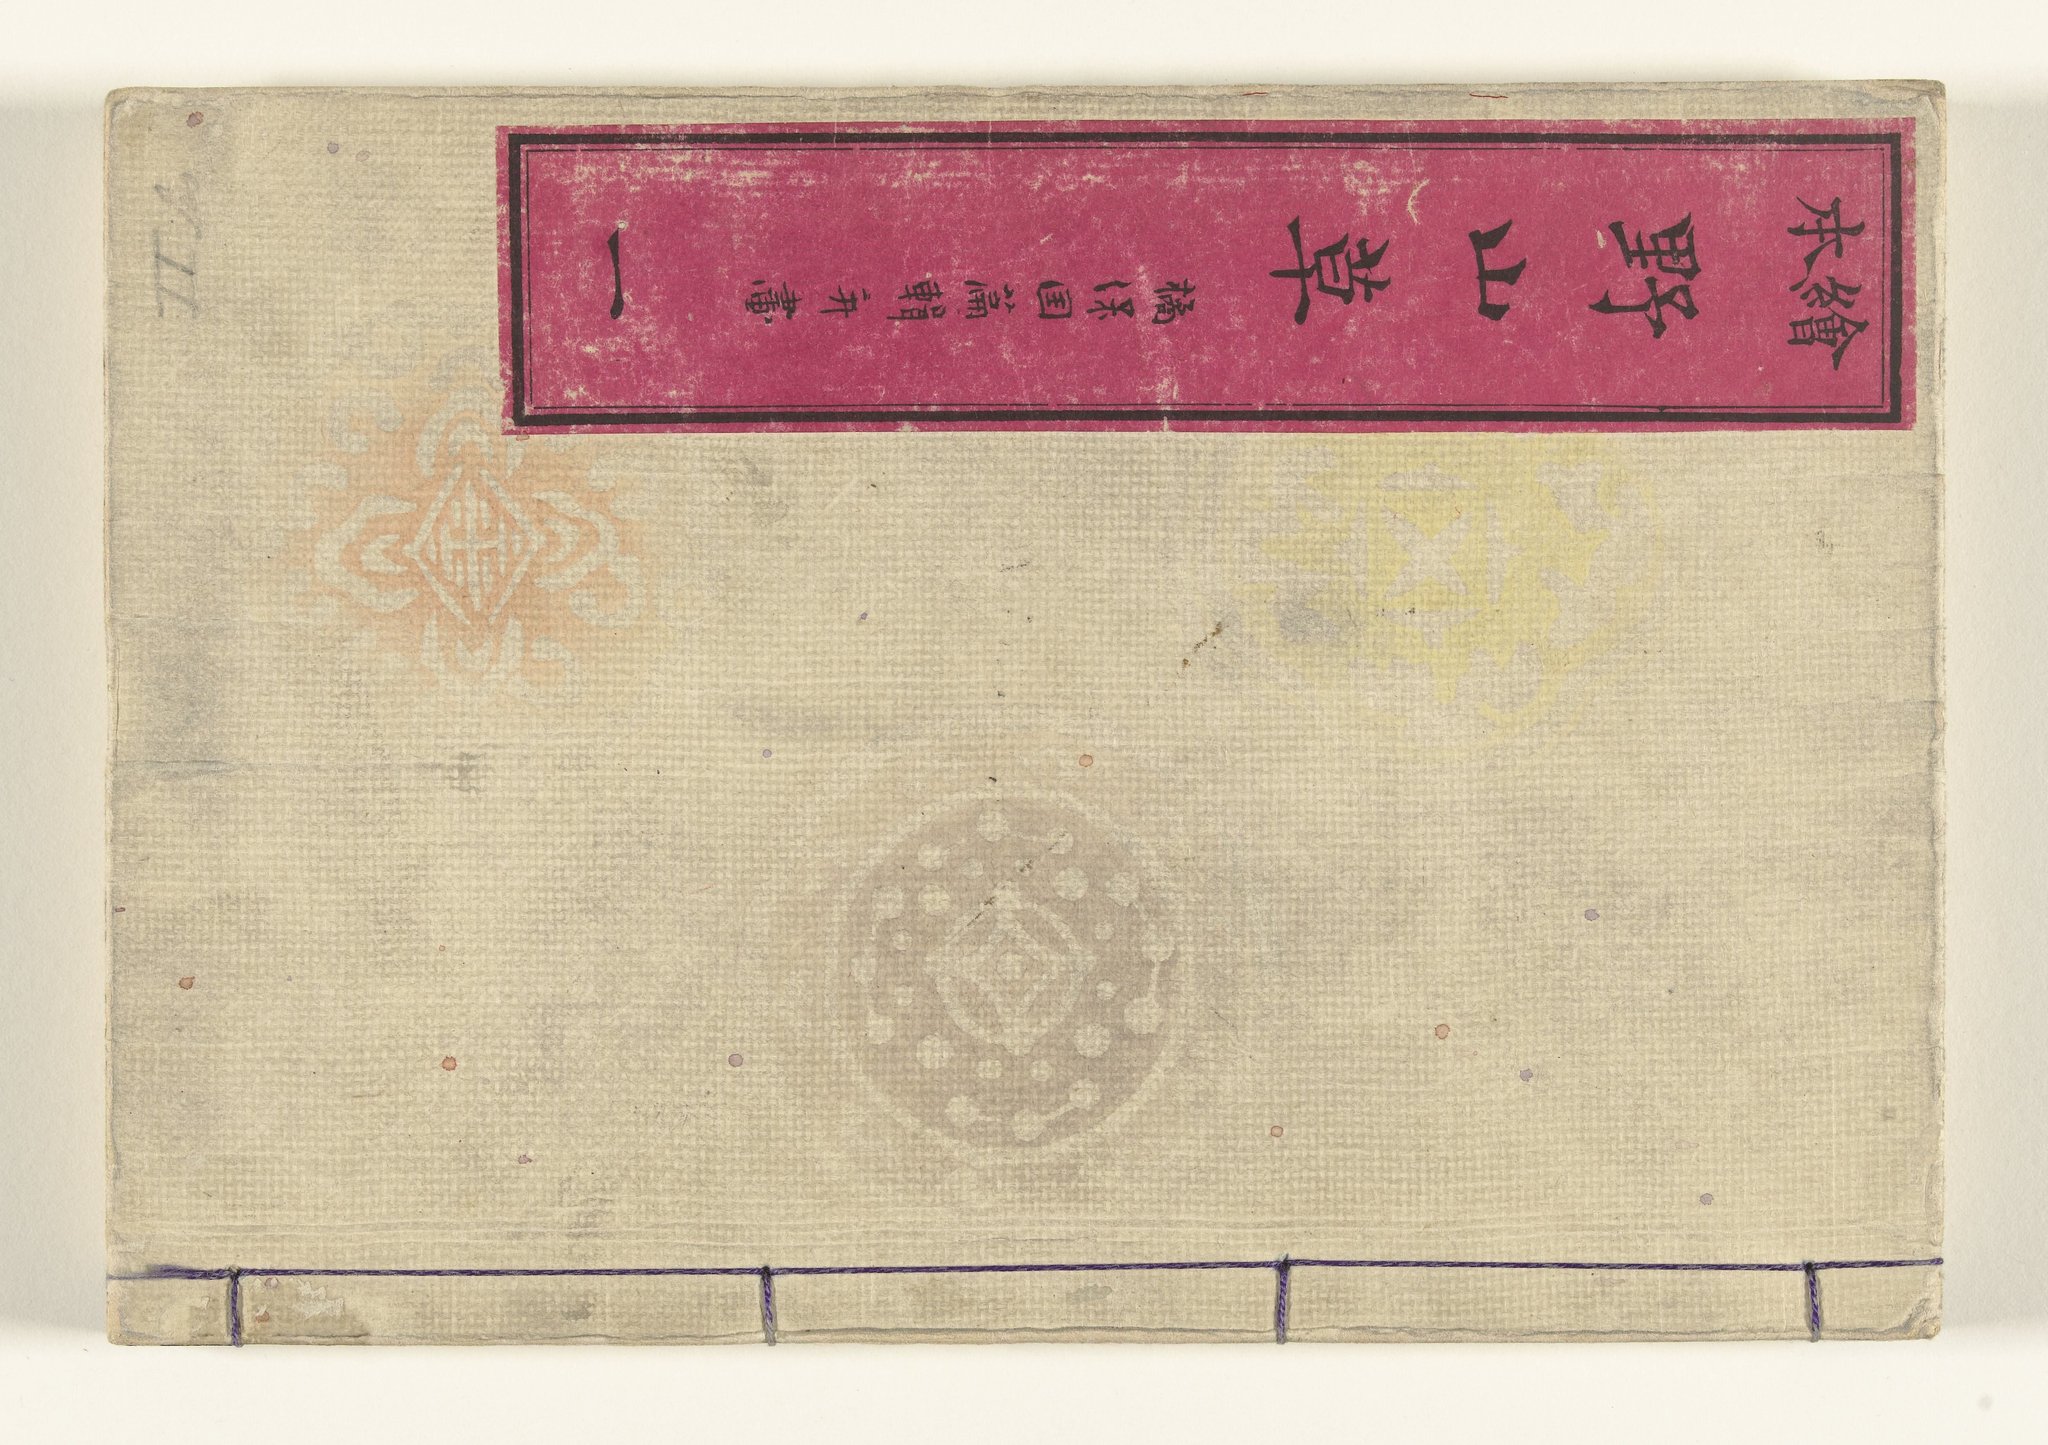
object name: book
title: Bloemen uit bergen en dalen - deel één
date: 1868-1912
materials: paper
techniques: woodcut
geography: osaka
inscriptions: collector's mark: ‘Rijksschool voor kunstnijverheid’ Lugt 3937